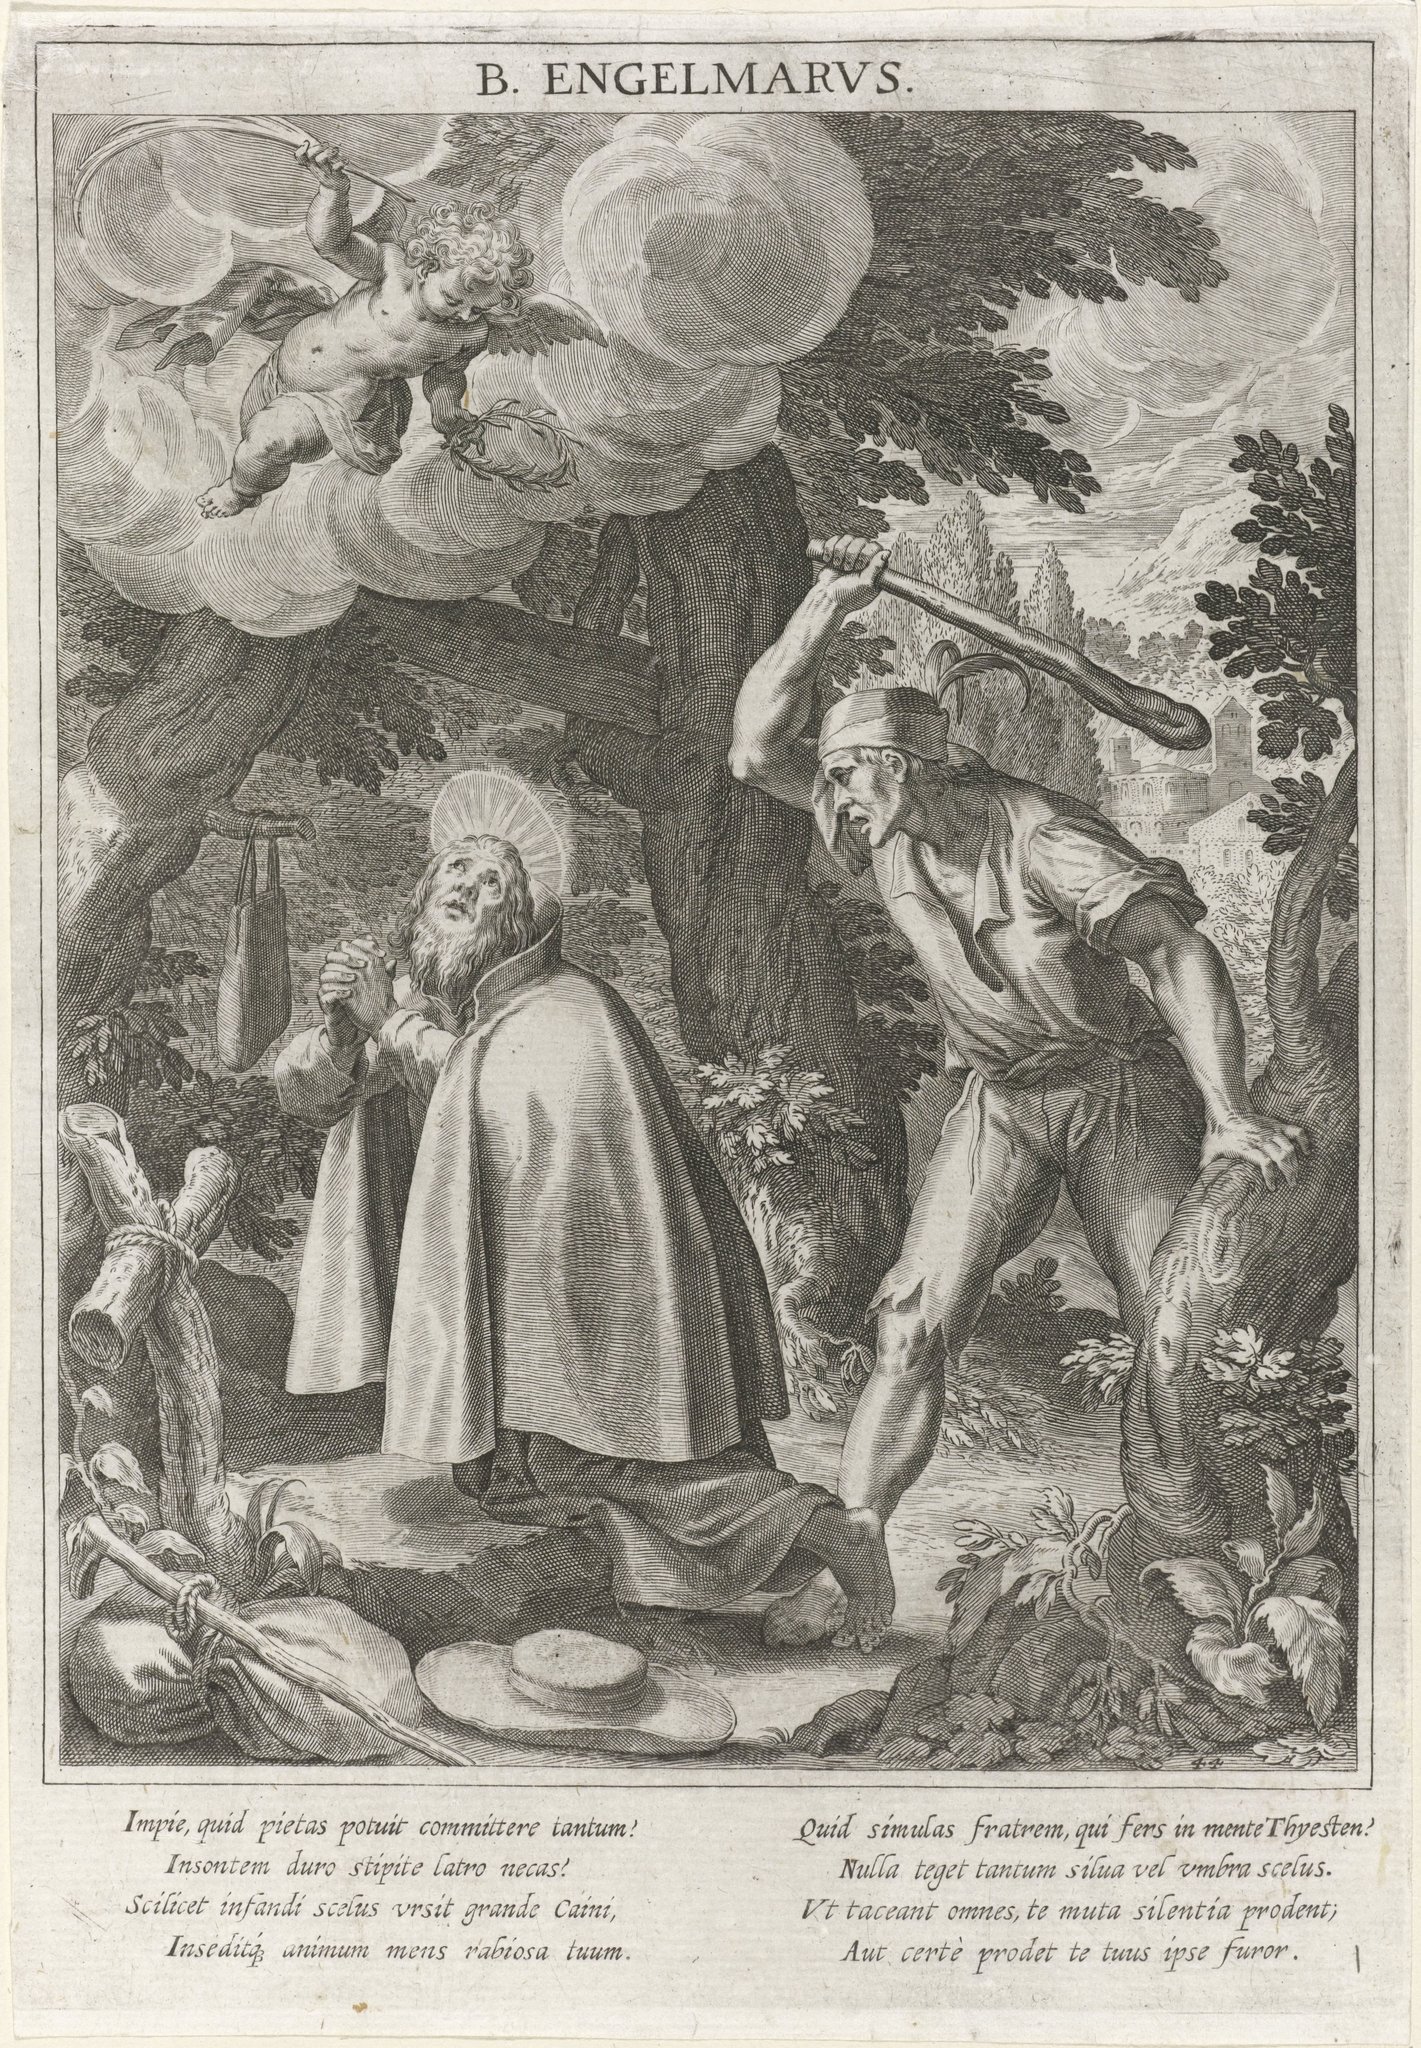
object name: print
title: B. Engelmarvs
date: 1615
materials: paper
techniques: engraving, etching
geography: munich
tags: violent death by blow on the head with object, male saints (with name), angels crowning and/or bringing palm-branches, anchorite, hermit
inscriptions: collector's mark: Lugt 240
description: Op de voorgrond wordt de H. Engelmarus van Passau in zijn kluis in de wildernis doodgeslagen door een bezoeker die hoopte een schat te vinden. Een engeltje daalt uit de hemel af om de ziel van de H. Engelmarus op te nemen. De prent heeft een Latijns onderschrift en is de 44ste prent van een 60-delige serie met als onderwerp de heiligen van Beieren.